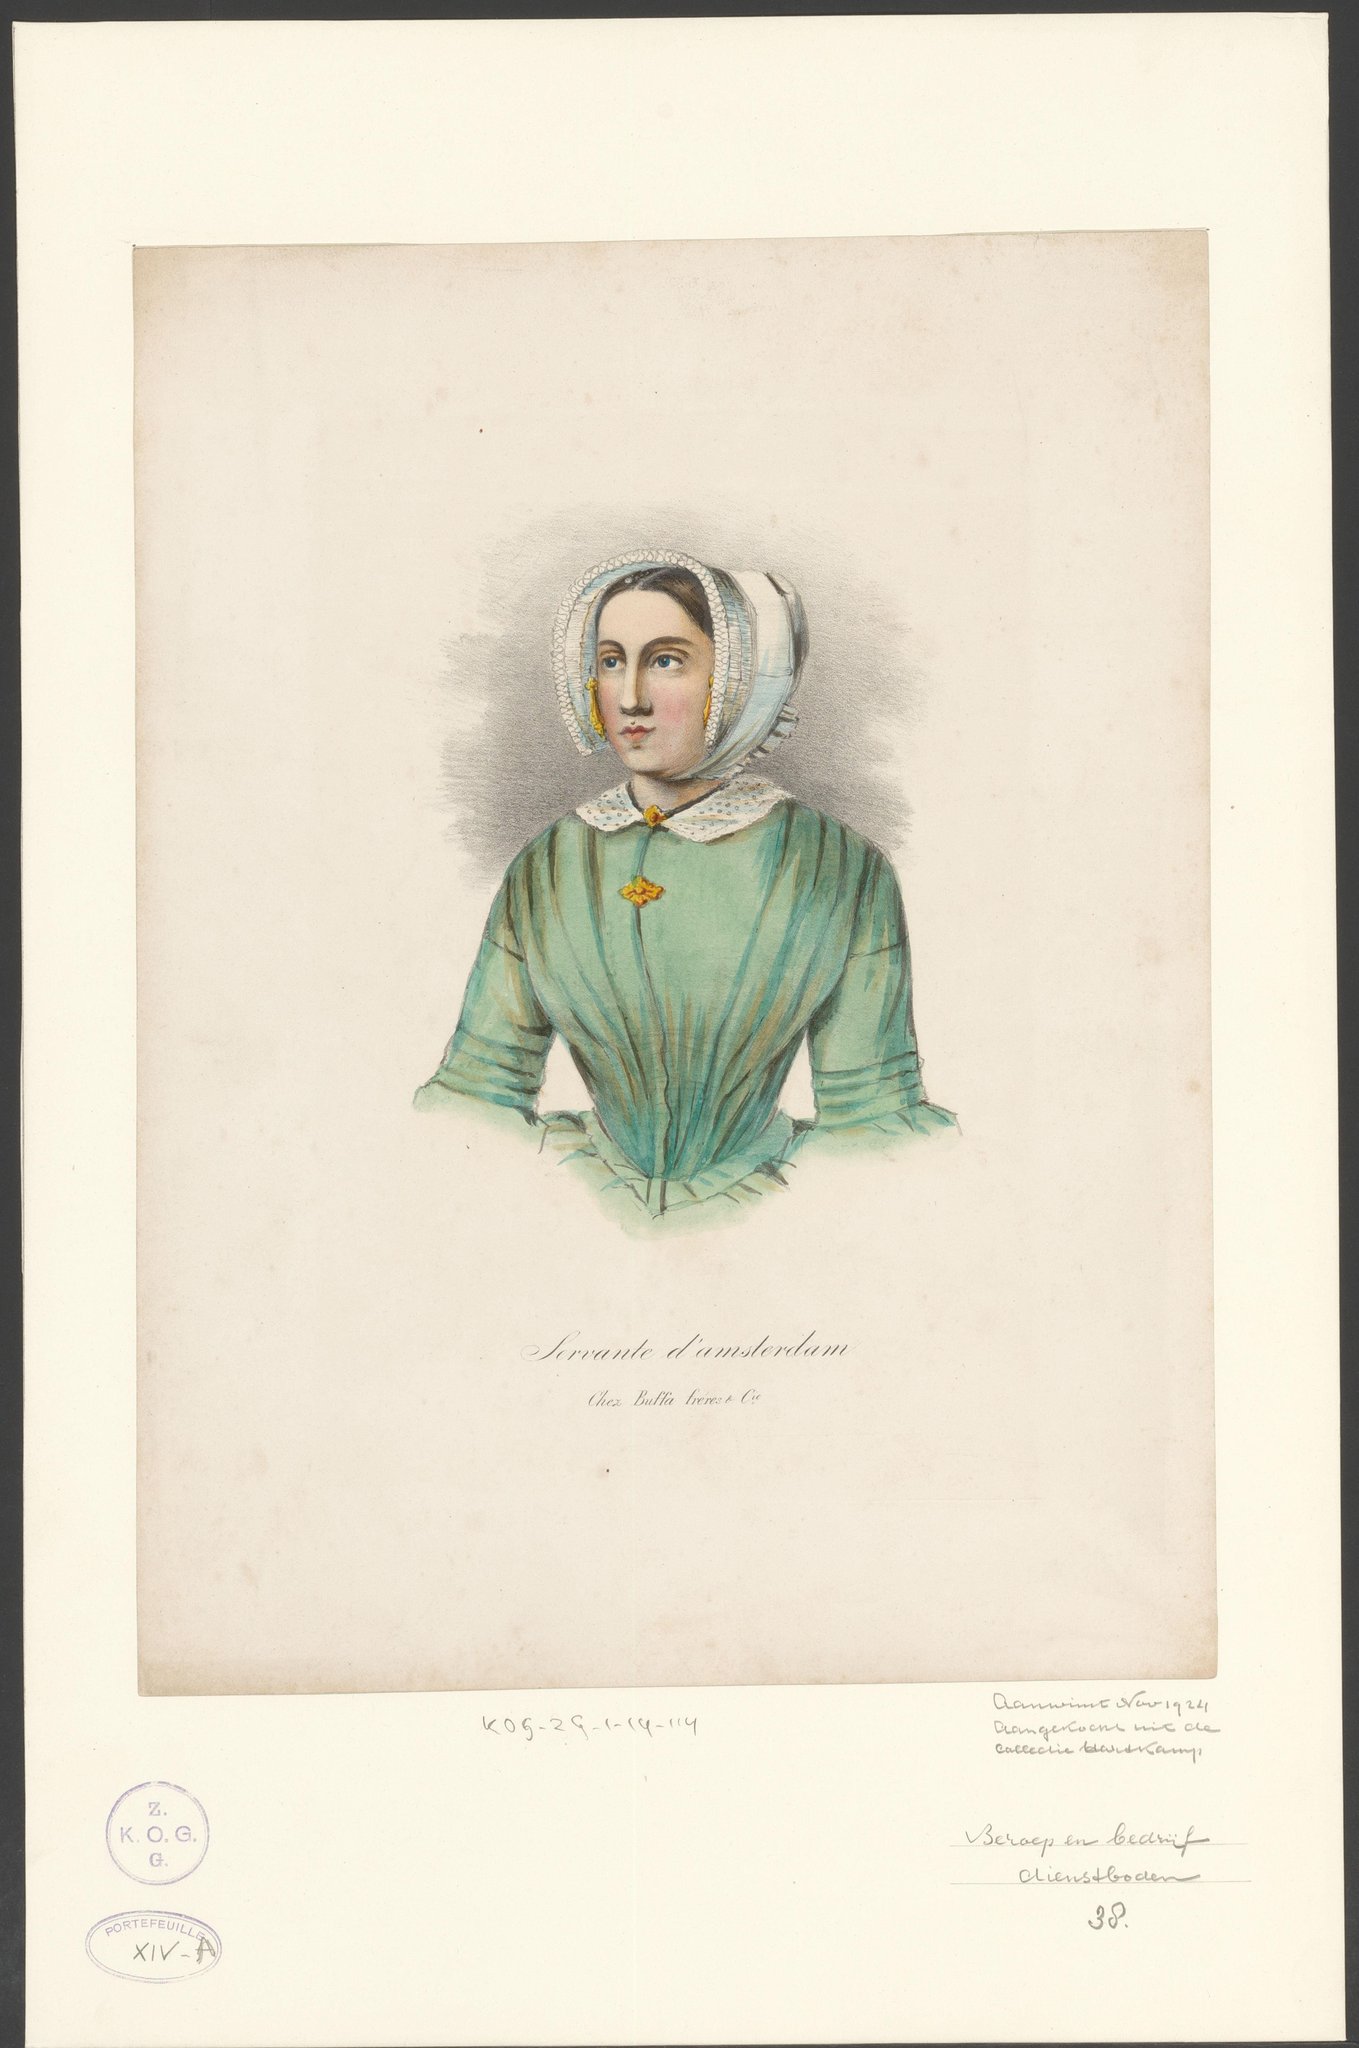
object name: print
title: Amsterdamse dienstbode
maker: Anonymous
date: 1830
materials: paper, varnish, watercolor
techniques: hand coloring, lithograph, varnishing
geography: amsterdam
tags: maid ~ house personnel, amsterdam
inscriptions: collector's mark:, collector's mark: Lugt 1641a, collector's mark: Lugt 1641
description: Een dienstbode van voren ten halve lijve met een geplooid mutsje, een kanten kraagje, een oorijzer, een ketting en een broche. Groene japon. Staat met de letter. Onderwerpsrubrieken binnen de Atlas Zeden en Gewoonten: Beroep en bedrijf. Vrouwelijk beroep en bedrijf. Dienstboden.